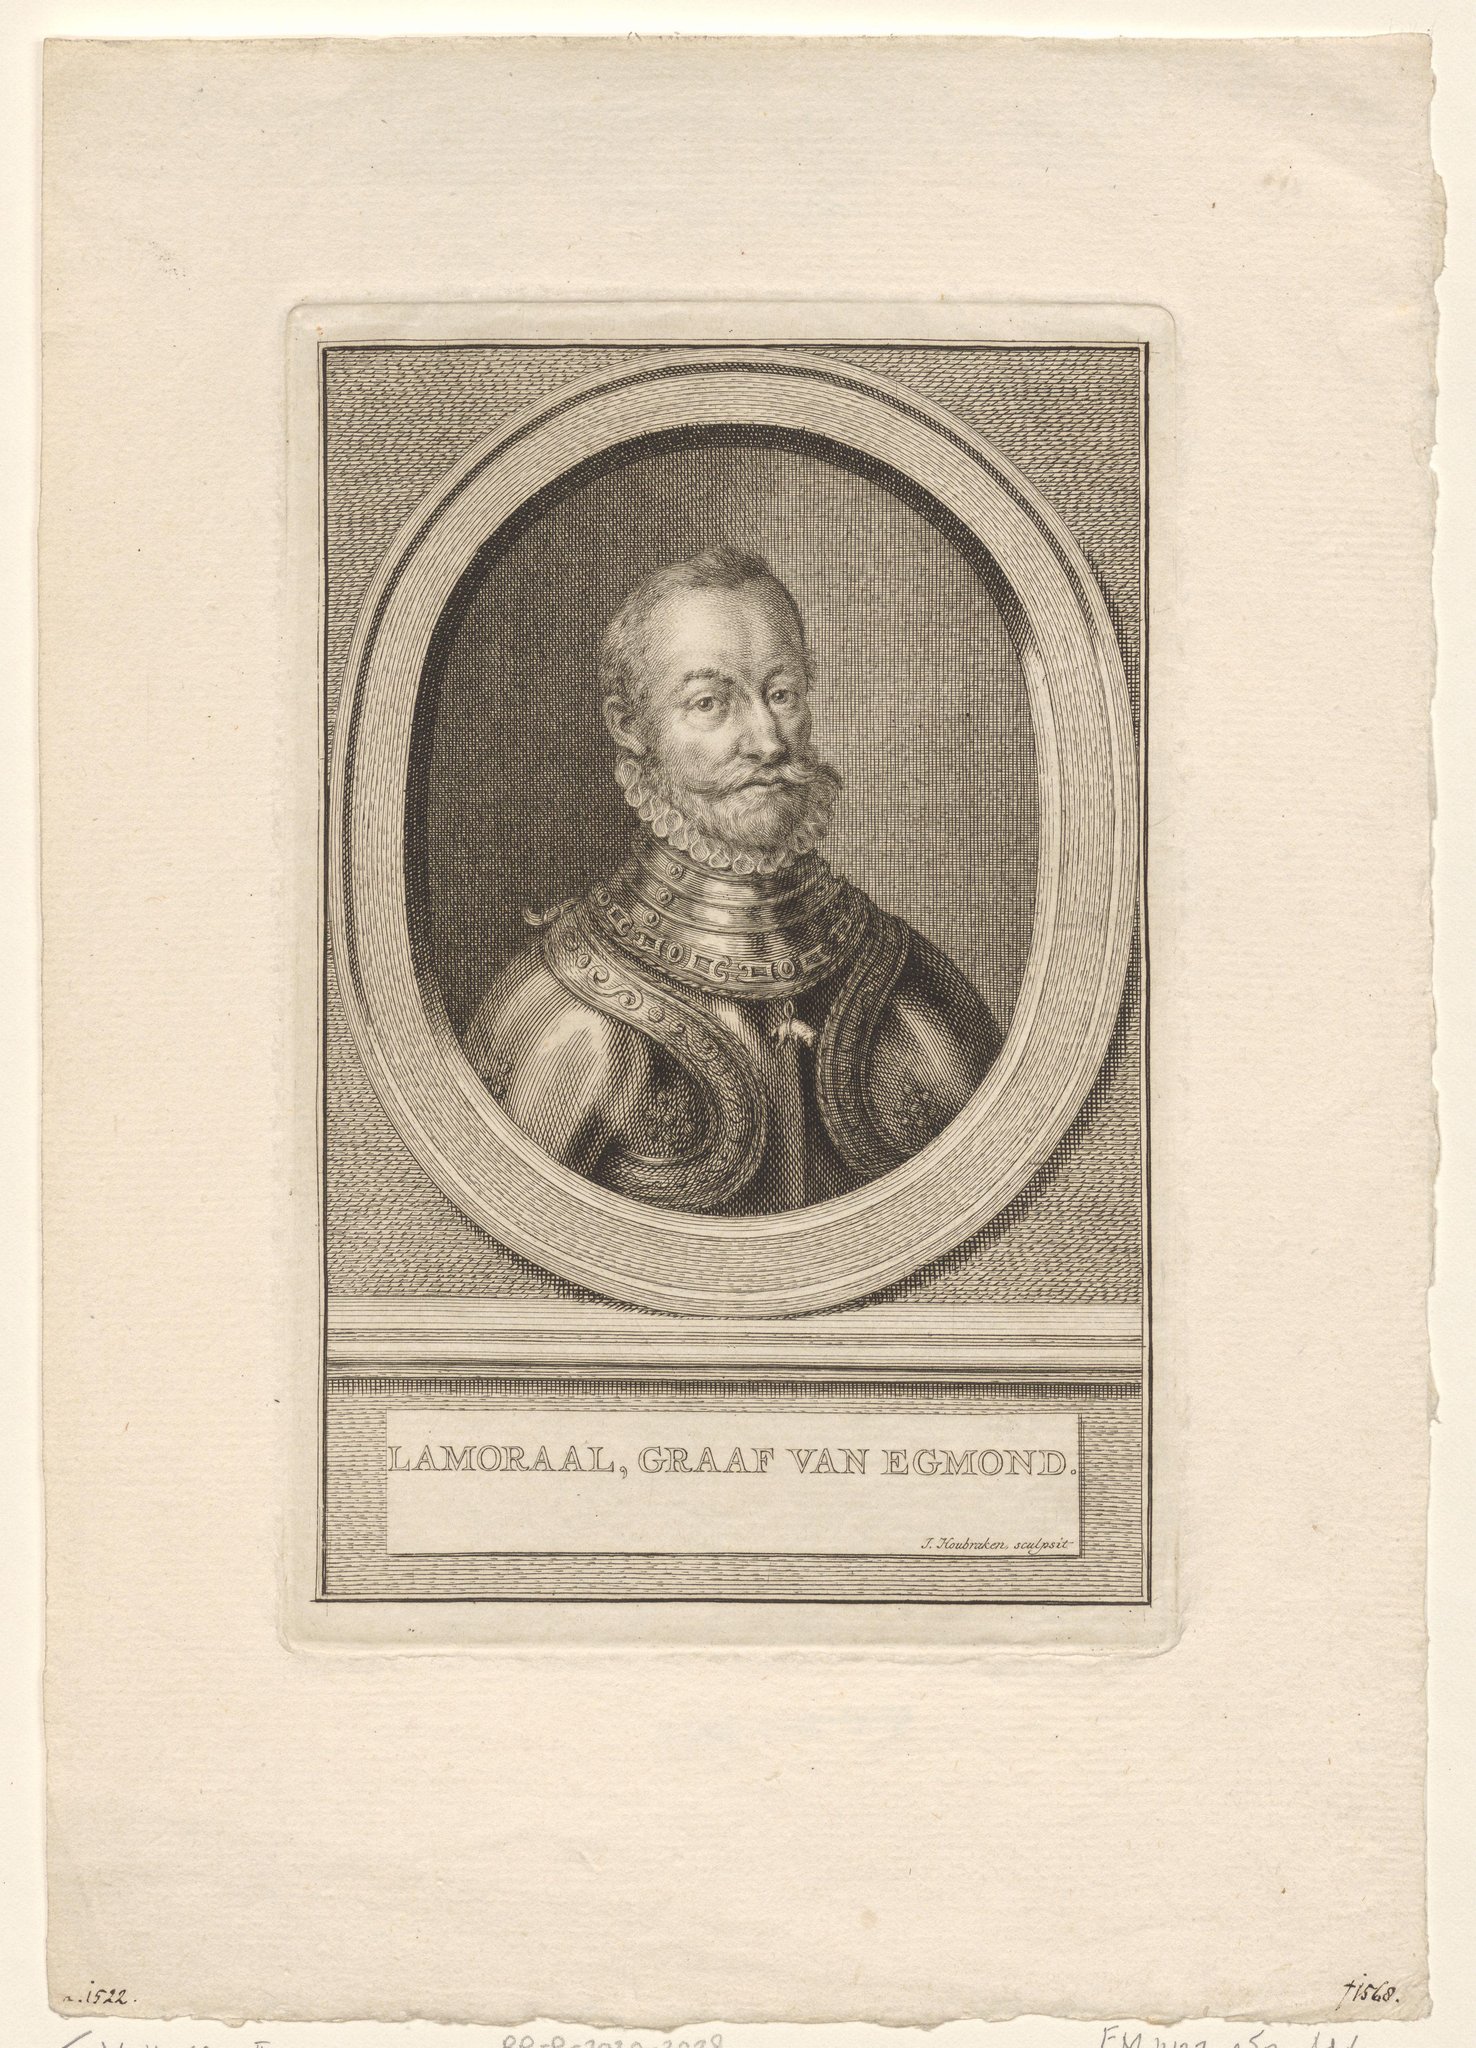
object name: book illustration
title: Portret van Lamoraal van Egmond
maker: jacob houbraken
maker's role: draughtsman, print maker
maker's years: 1698-1780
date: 1752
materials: paper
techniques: engraving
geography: amsterdam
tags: brussels, earl, armour, historical persons, knighthood order of the golden fleece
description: Prent waarschijnlijk uit: Wagenaar, Jan. Vaderlantsche historie (...). Amsterdam: Isaak Tirion, 1753, dl. 6. Prent ook gebruikt in de editie uit 1792 en waarschijnlijk ook in de editie van 1770.